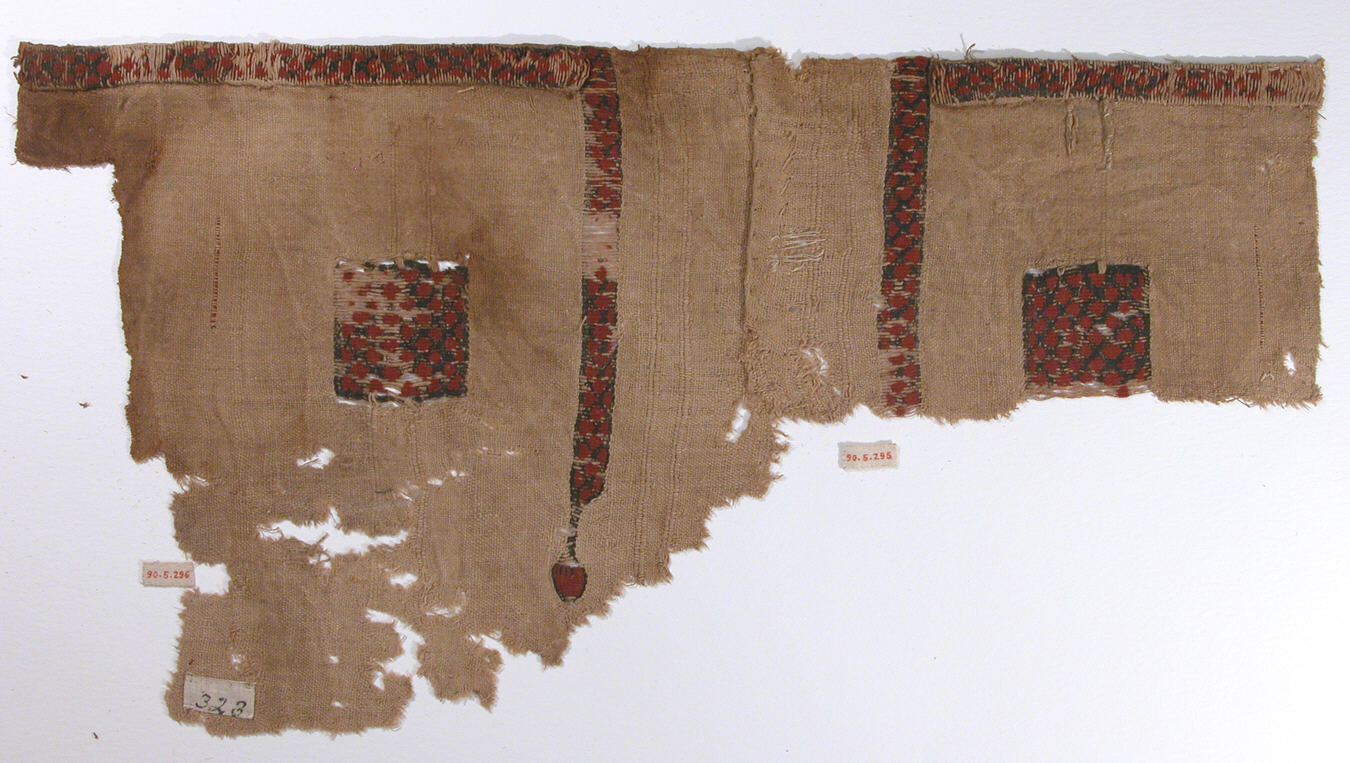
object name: textile fragment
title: Fragment of a Tunic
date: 301-500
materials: linen, wool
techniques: weave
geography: egypt